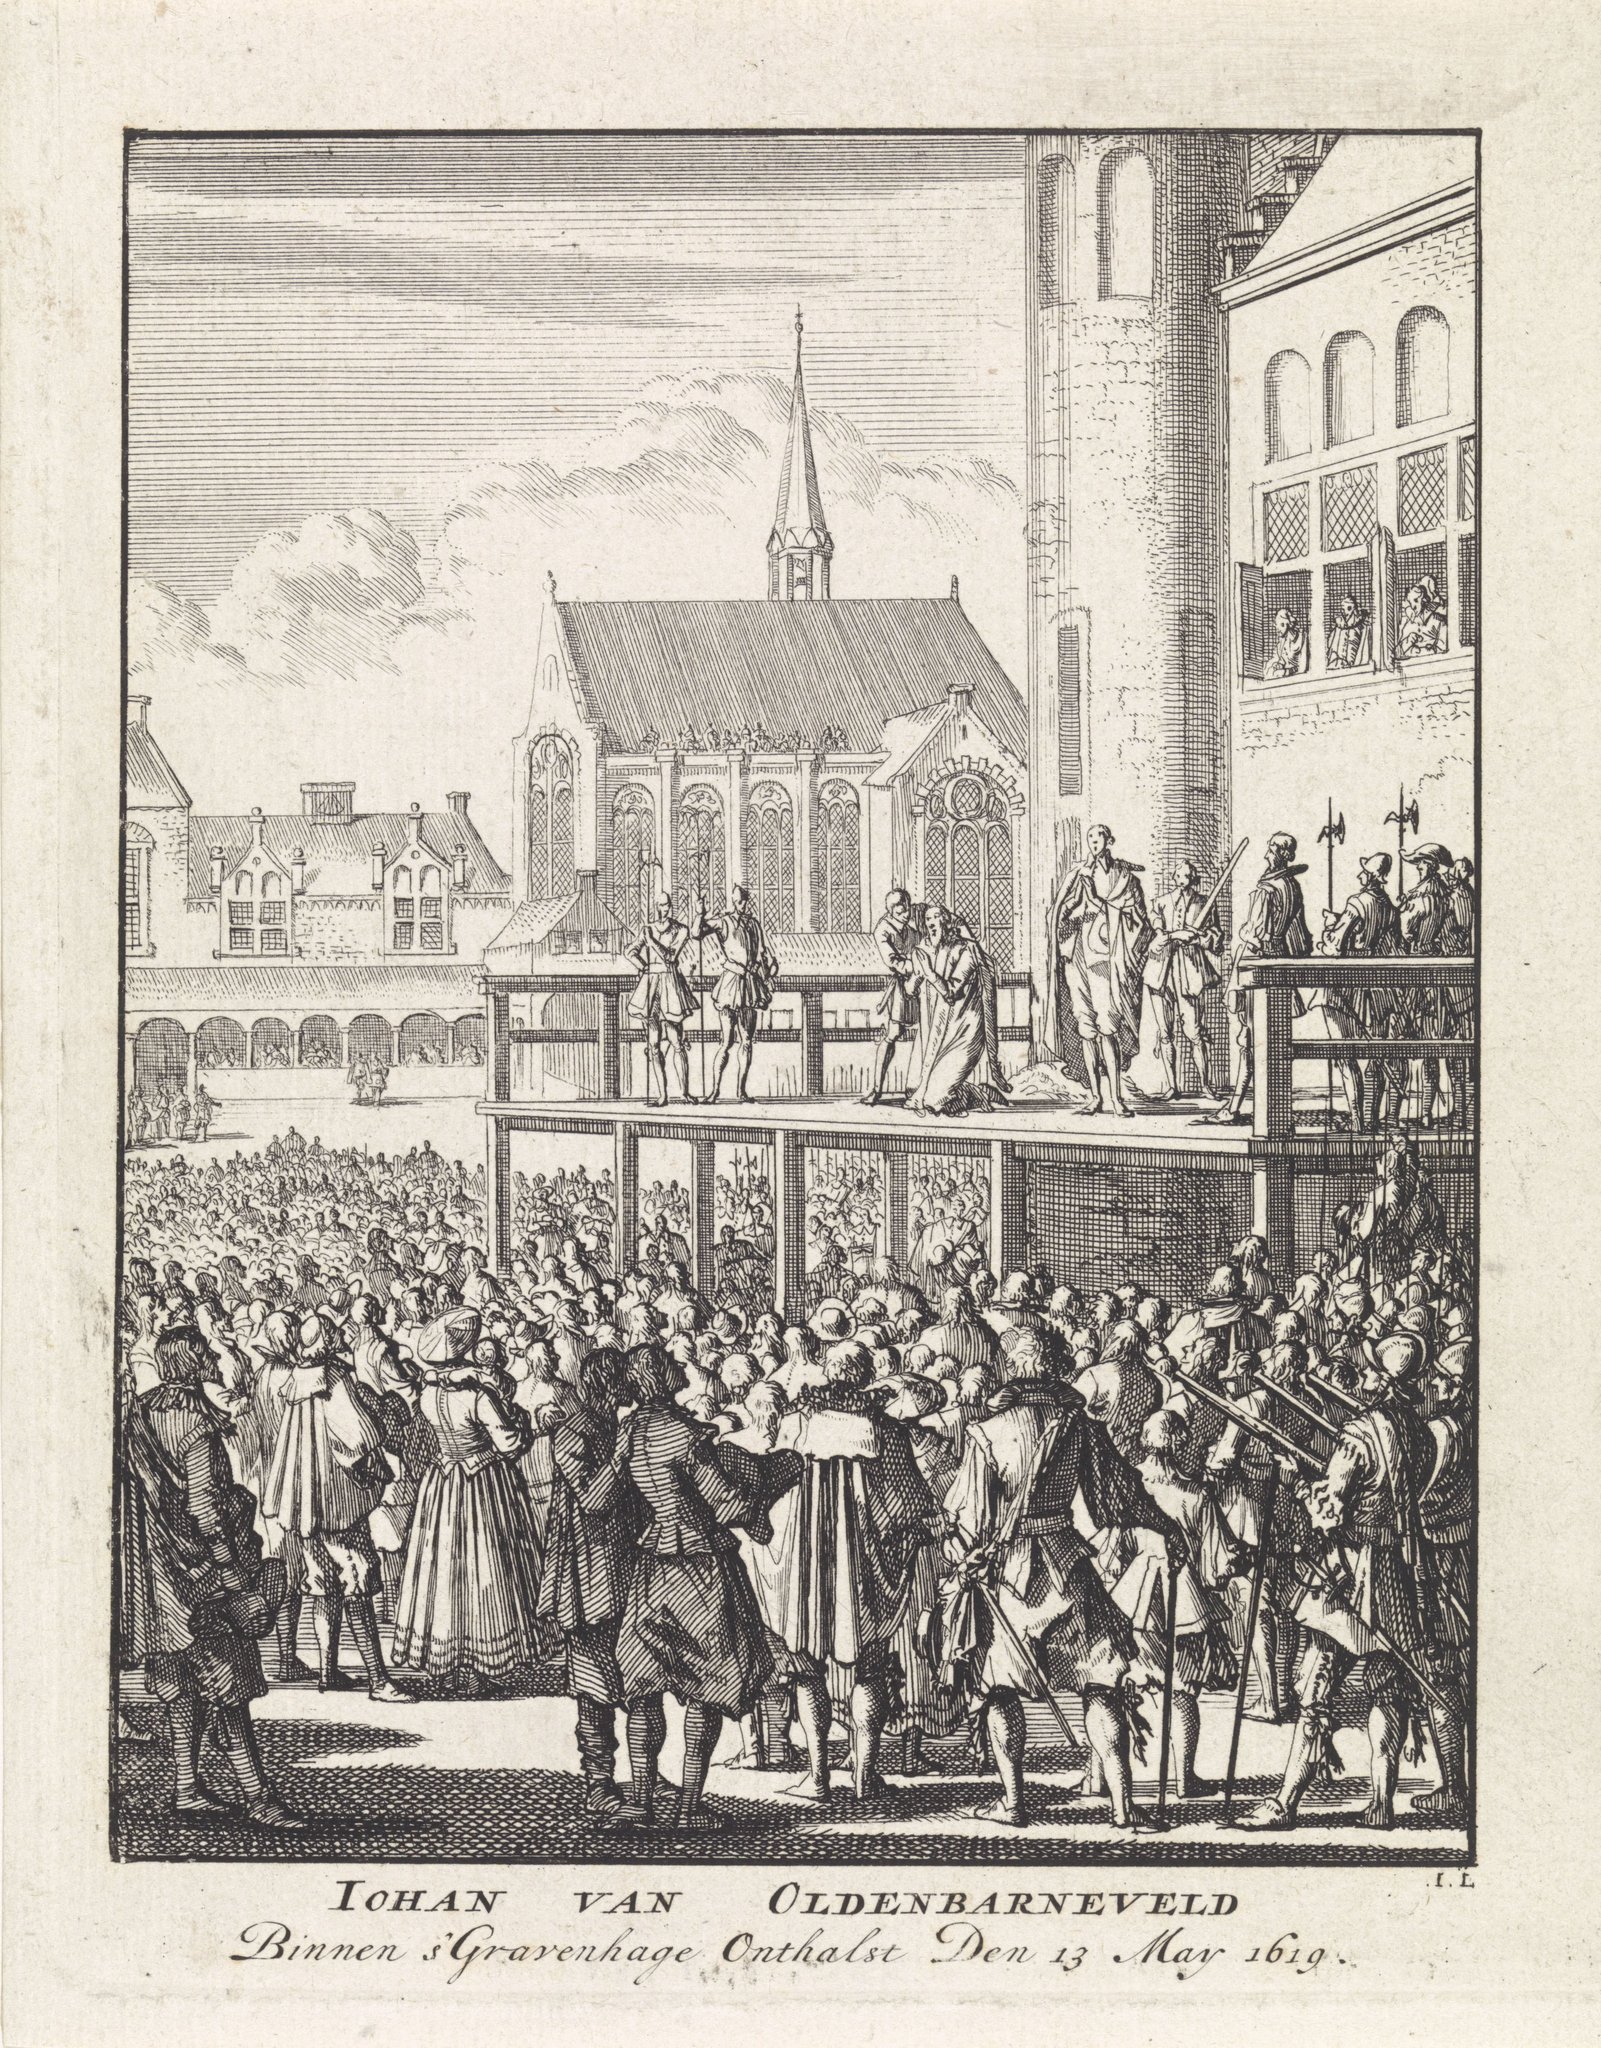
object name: print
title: Iohan van Oldenbarneveld binnen s'Gravenhage onthalst den 13 may 1619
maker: jan luyken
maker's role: draughtsman, print maker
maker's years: 1649-1712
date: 1698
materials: paper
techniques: engraving, etching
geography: amsterdam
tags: johan van oldenbarnevelt, maurice (prince of orange), on the scaffold or place of execution, violent death by beheading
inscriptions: collector's mark: Lugt 2228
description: Andere staat van prent ook gebruikt in: Bosch, Lambert van den. Treur-toonneel der doorluchtige mannen, of op- en ondergang der grooten, vertoont in de rampzalige geschiedenissen van (…). 3 delen. Amsterdam: Jan Claesz ten Hoorn, 1698, dl. 2, afd. 4, p. 61.